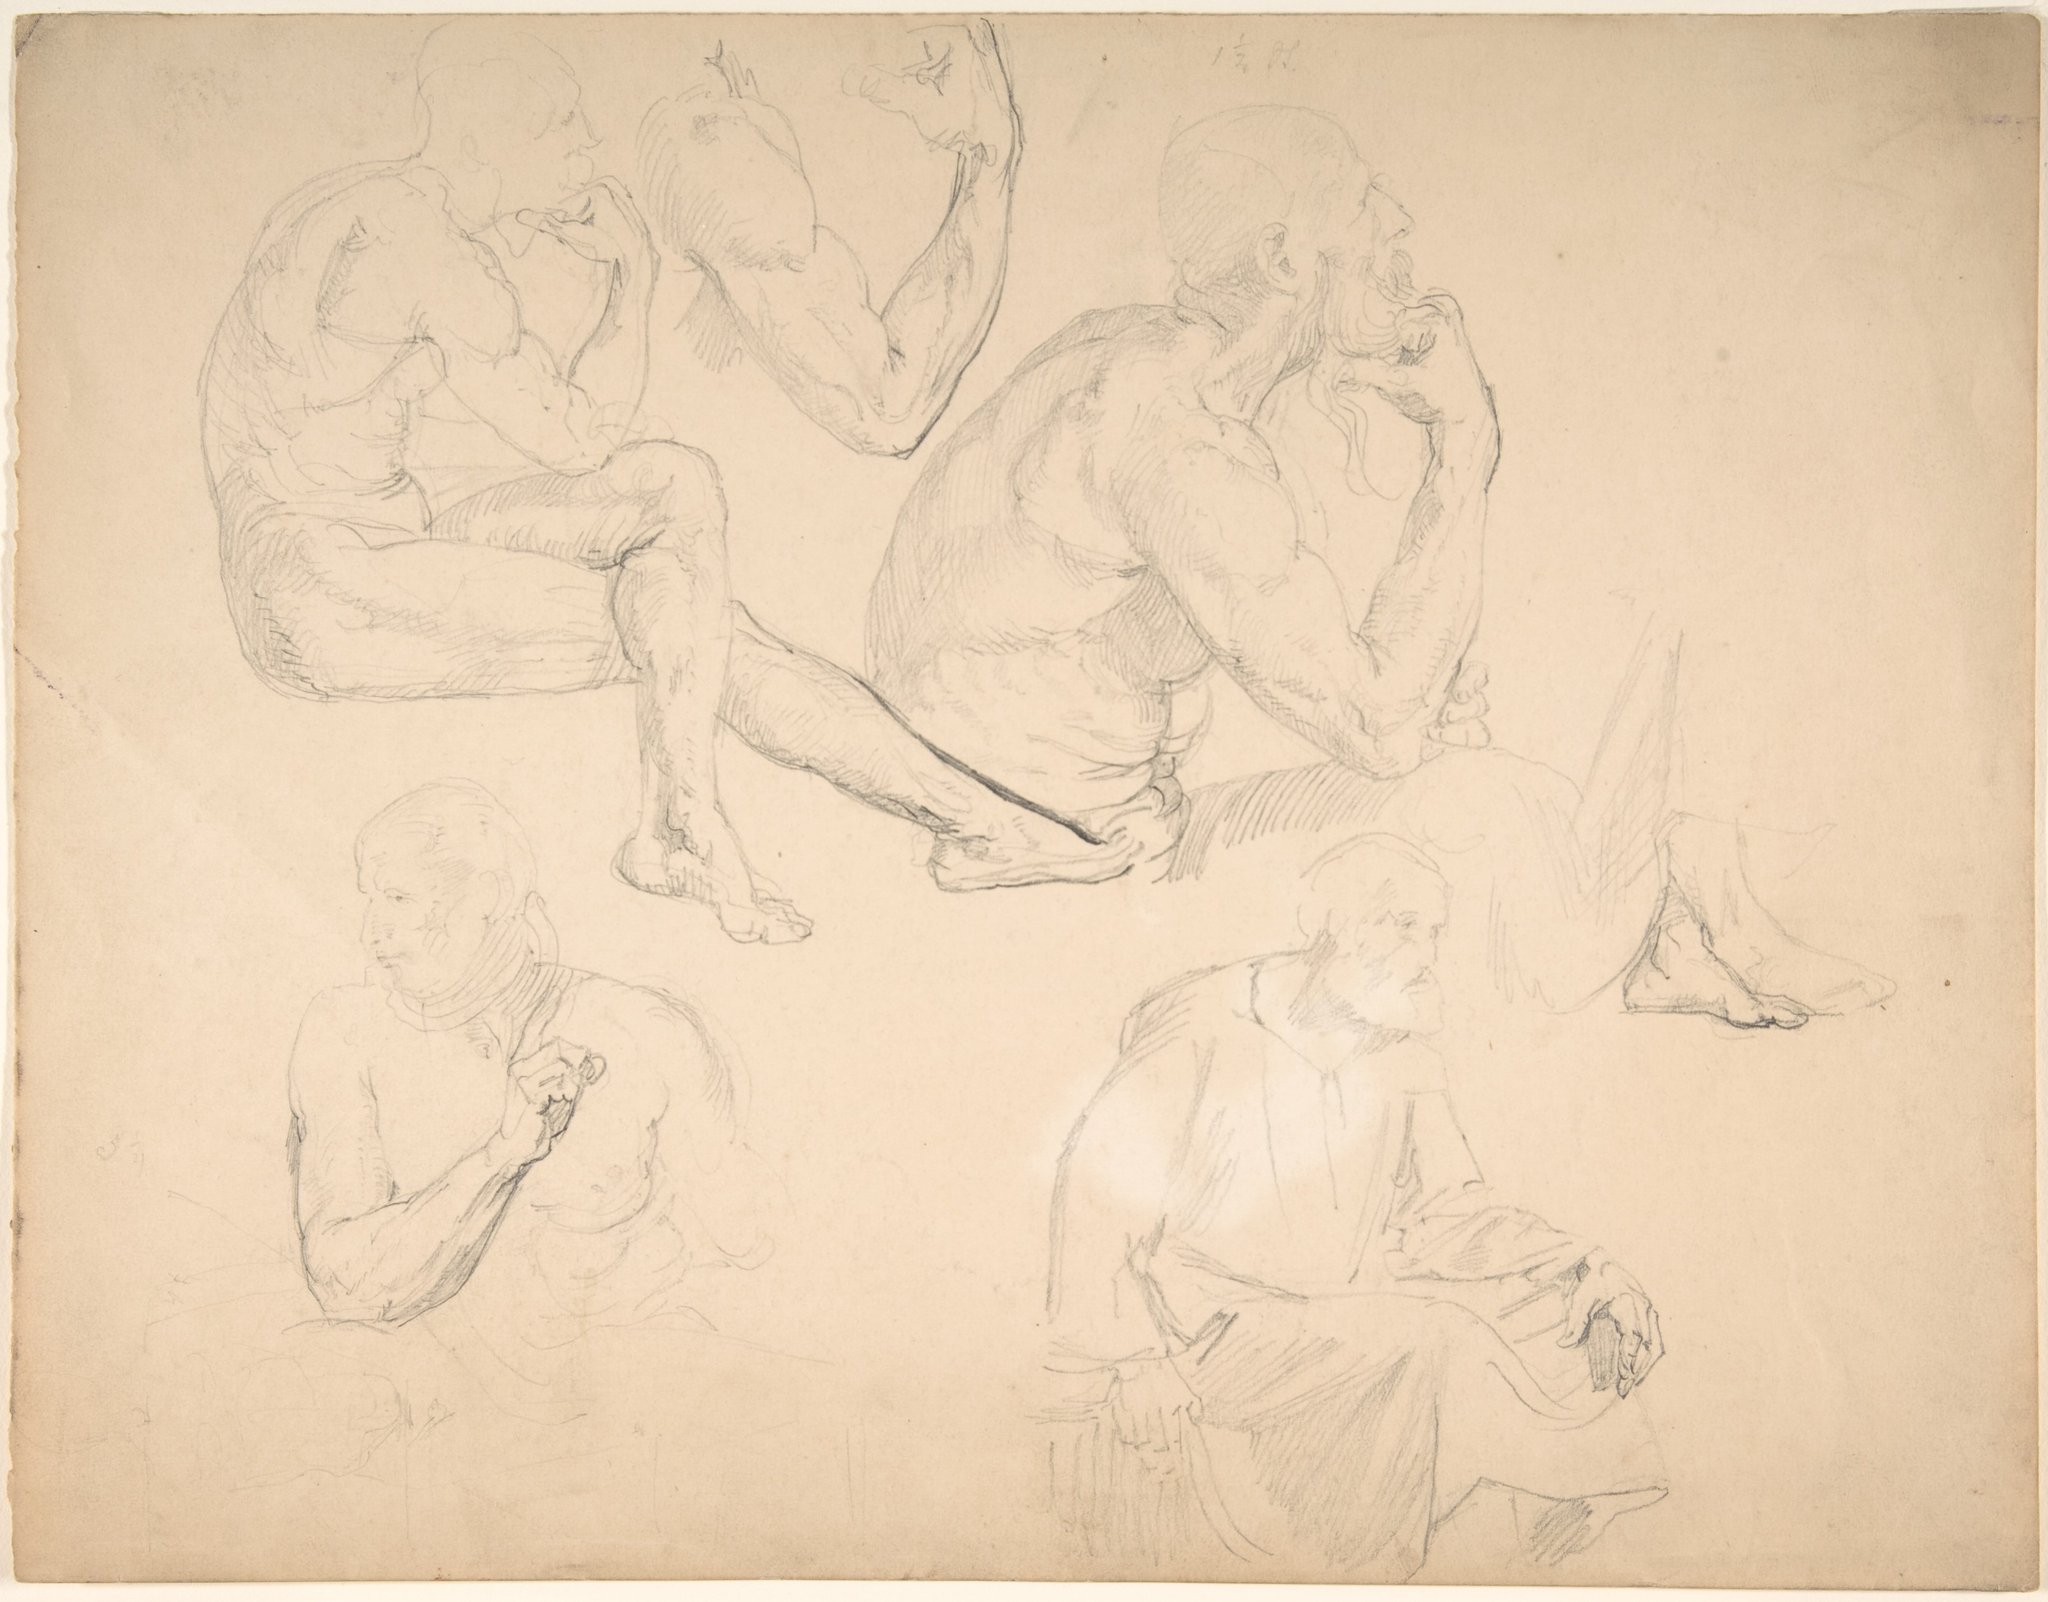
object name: drawing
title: Studies of a Seated Bearded Man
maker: eduard julius friedrich bendemann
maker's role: artist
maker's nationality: german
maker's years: 1811-1889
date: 1834-1866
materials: graphite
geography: germany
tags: men,male nudes,profiles